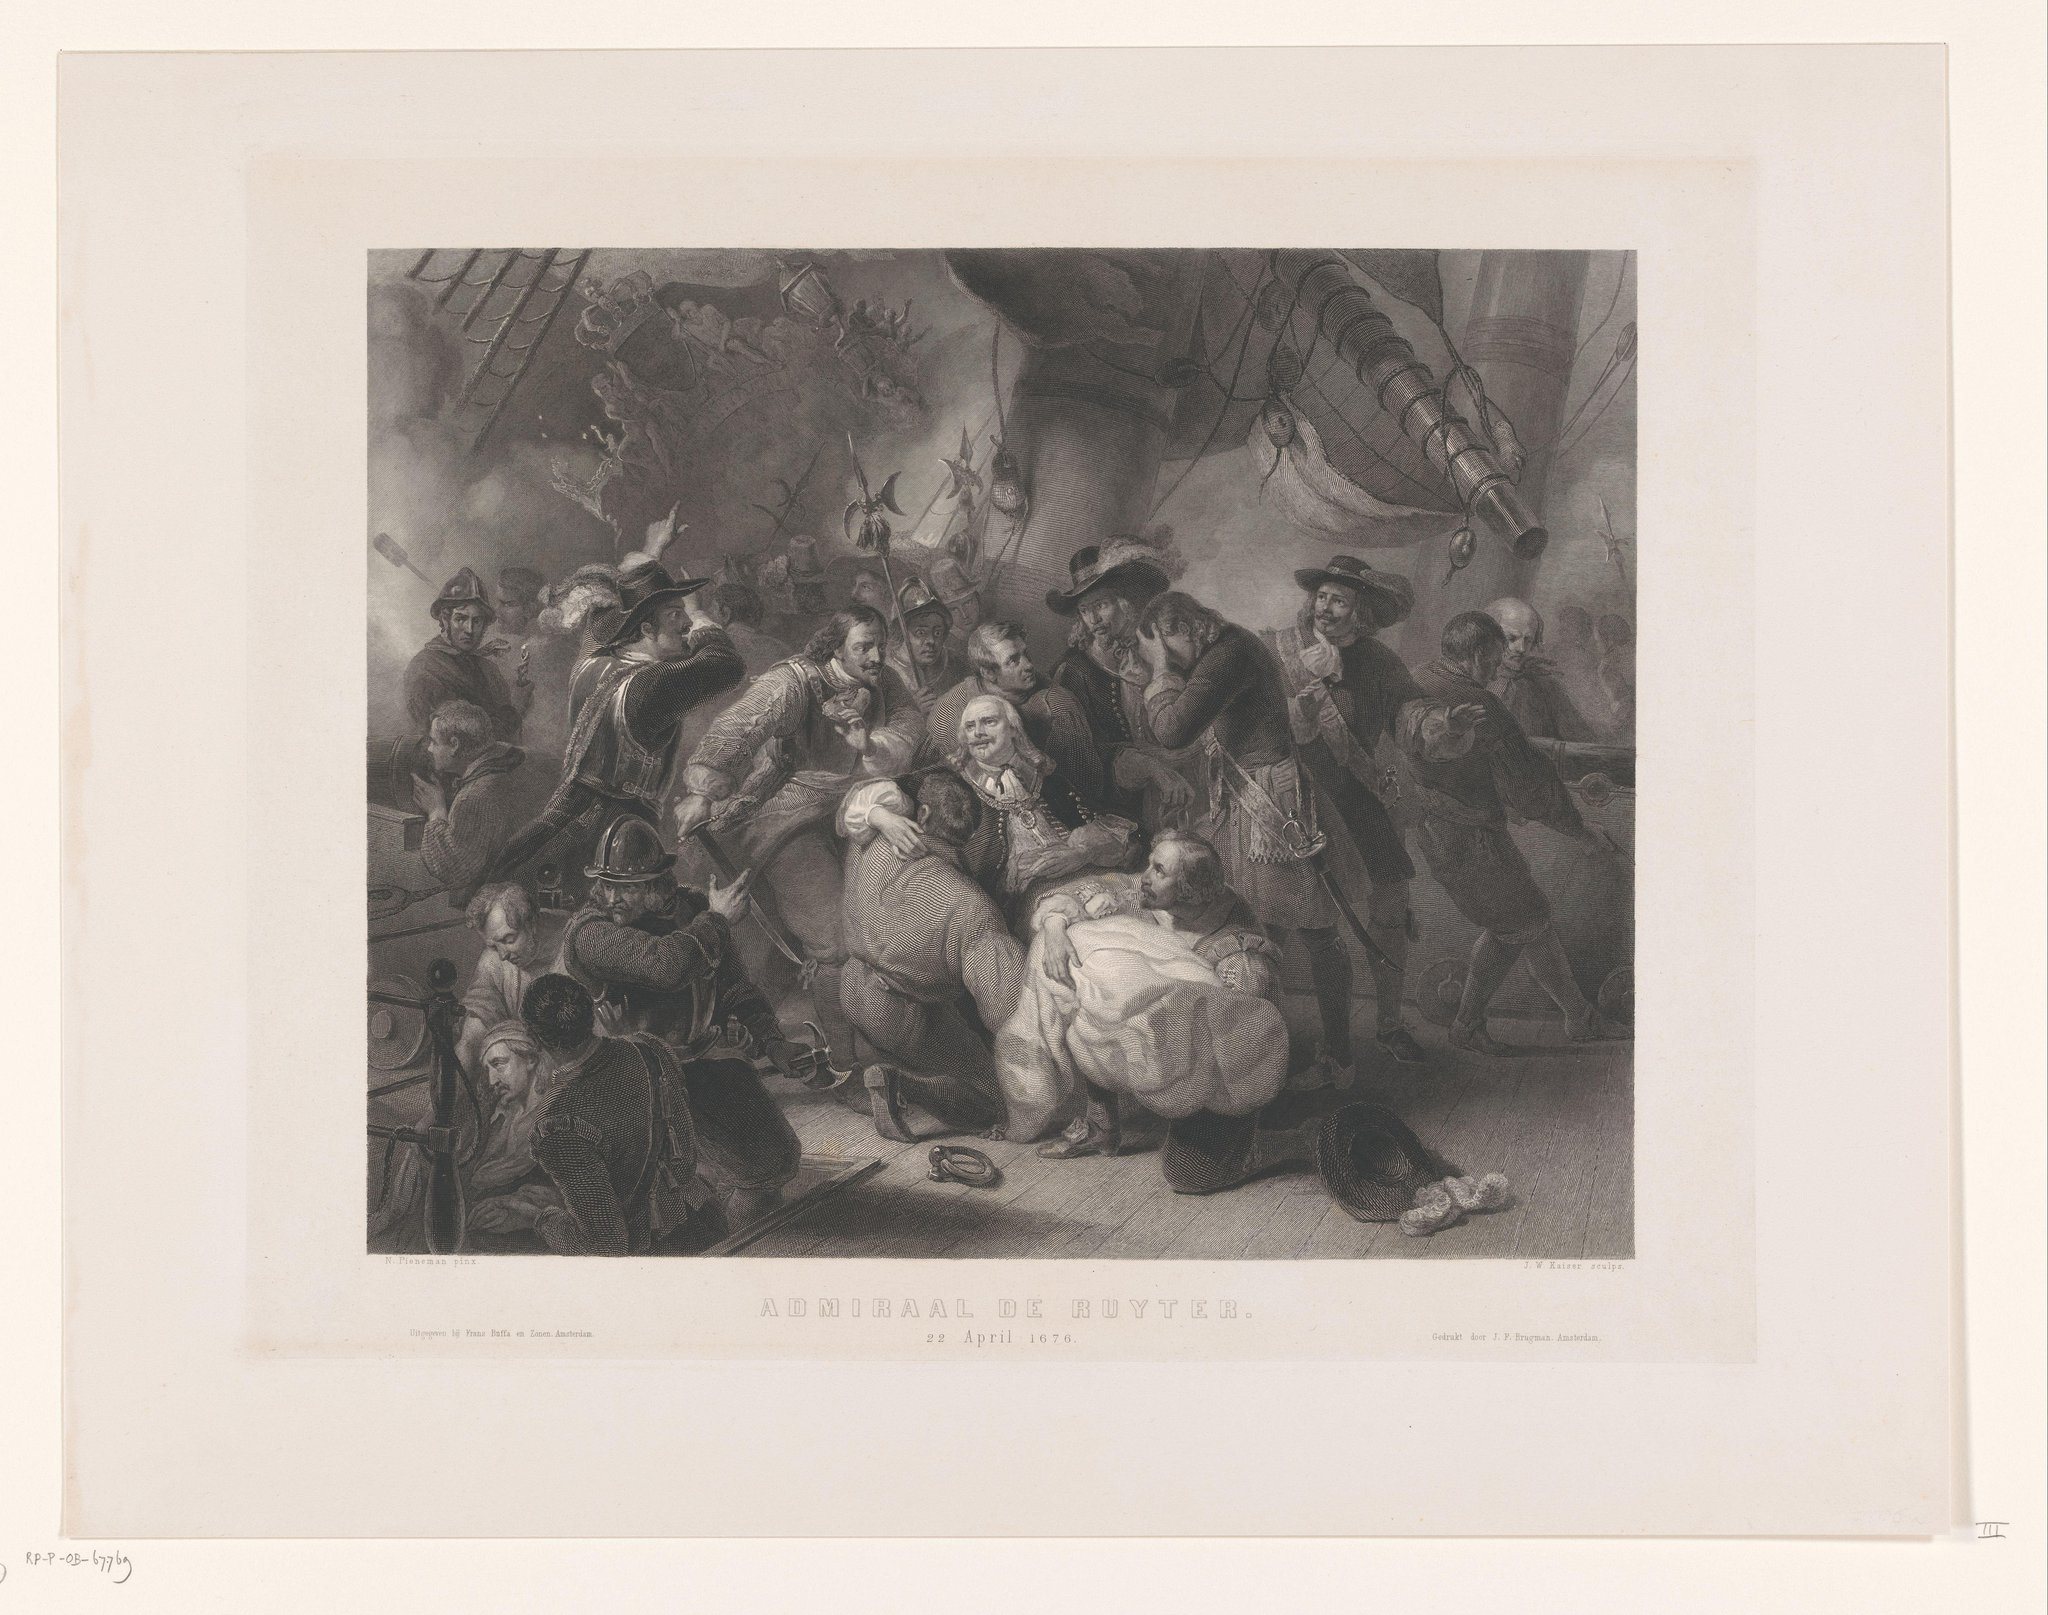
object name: print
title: Admiraal de Ruyter. 22 April 1676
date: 1845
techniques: printmaking, engraving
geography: amsterdam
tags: flushing, michiel adriaenszoon de ruyter, medical aid and nursing of the sick and wounded, battle (+ naval force), battle of augusta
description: Admiraal Michiel Adriaenszoon de Ruyter raakt dodelijk gewond tijdens de zeeslag bij Agosta op 22 april 1676 tussen een gecombineerd Hollands-Spaanse vloot onder De Ruyter en een Franse vloot onder Abraham Duquesne met elkaar in gevecht. In alle hevigheid van de slag wordt De Ruyter door zijn bemanning in een laken gewikkeld en naar zijn kajuit gedragen.